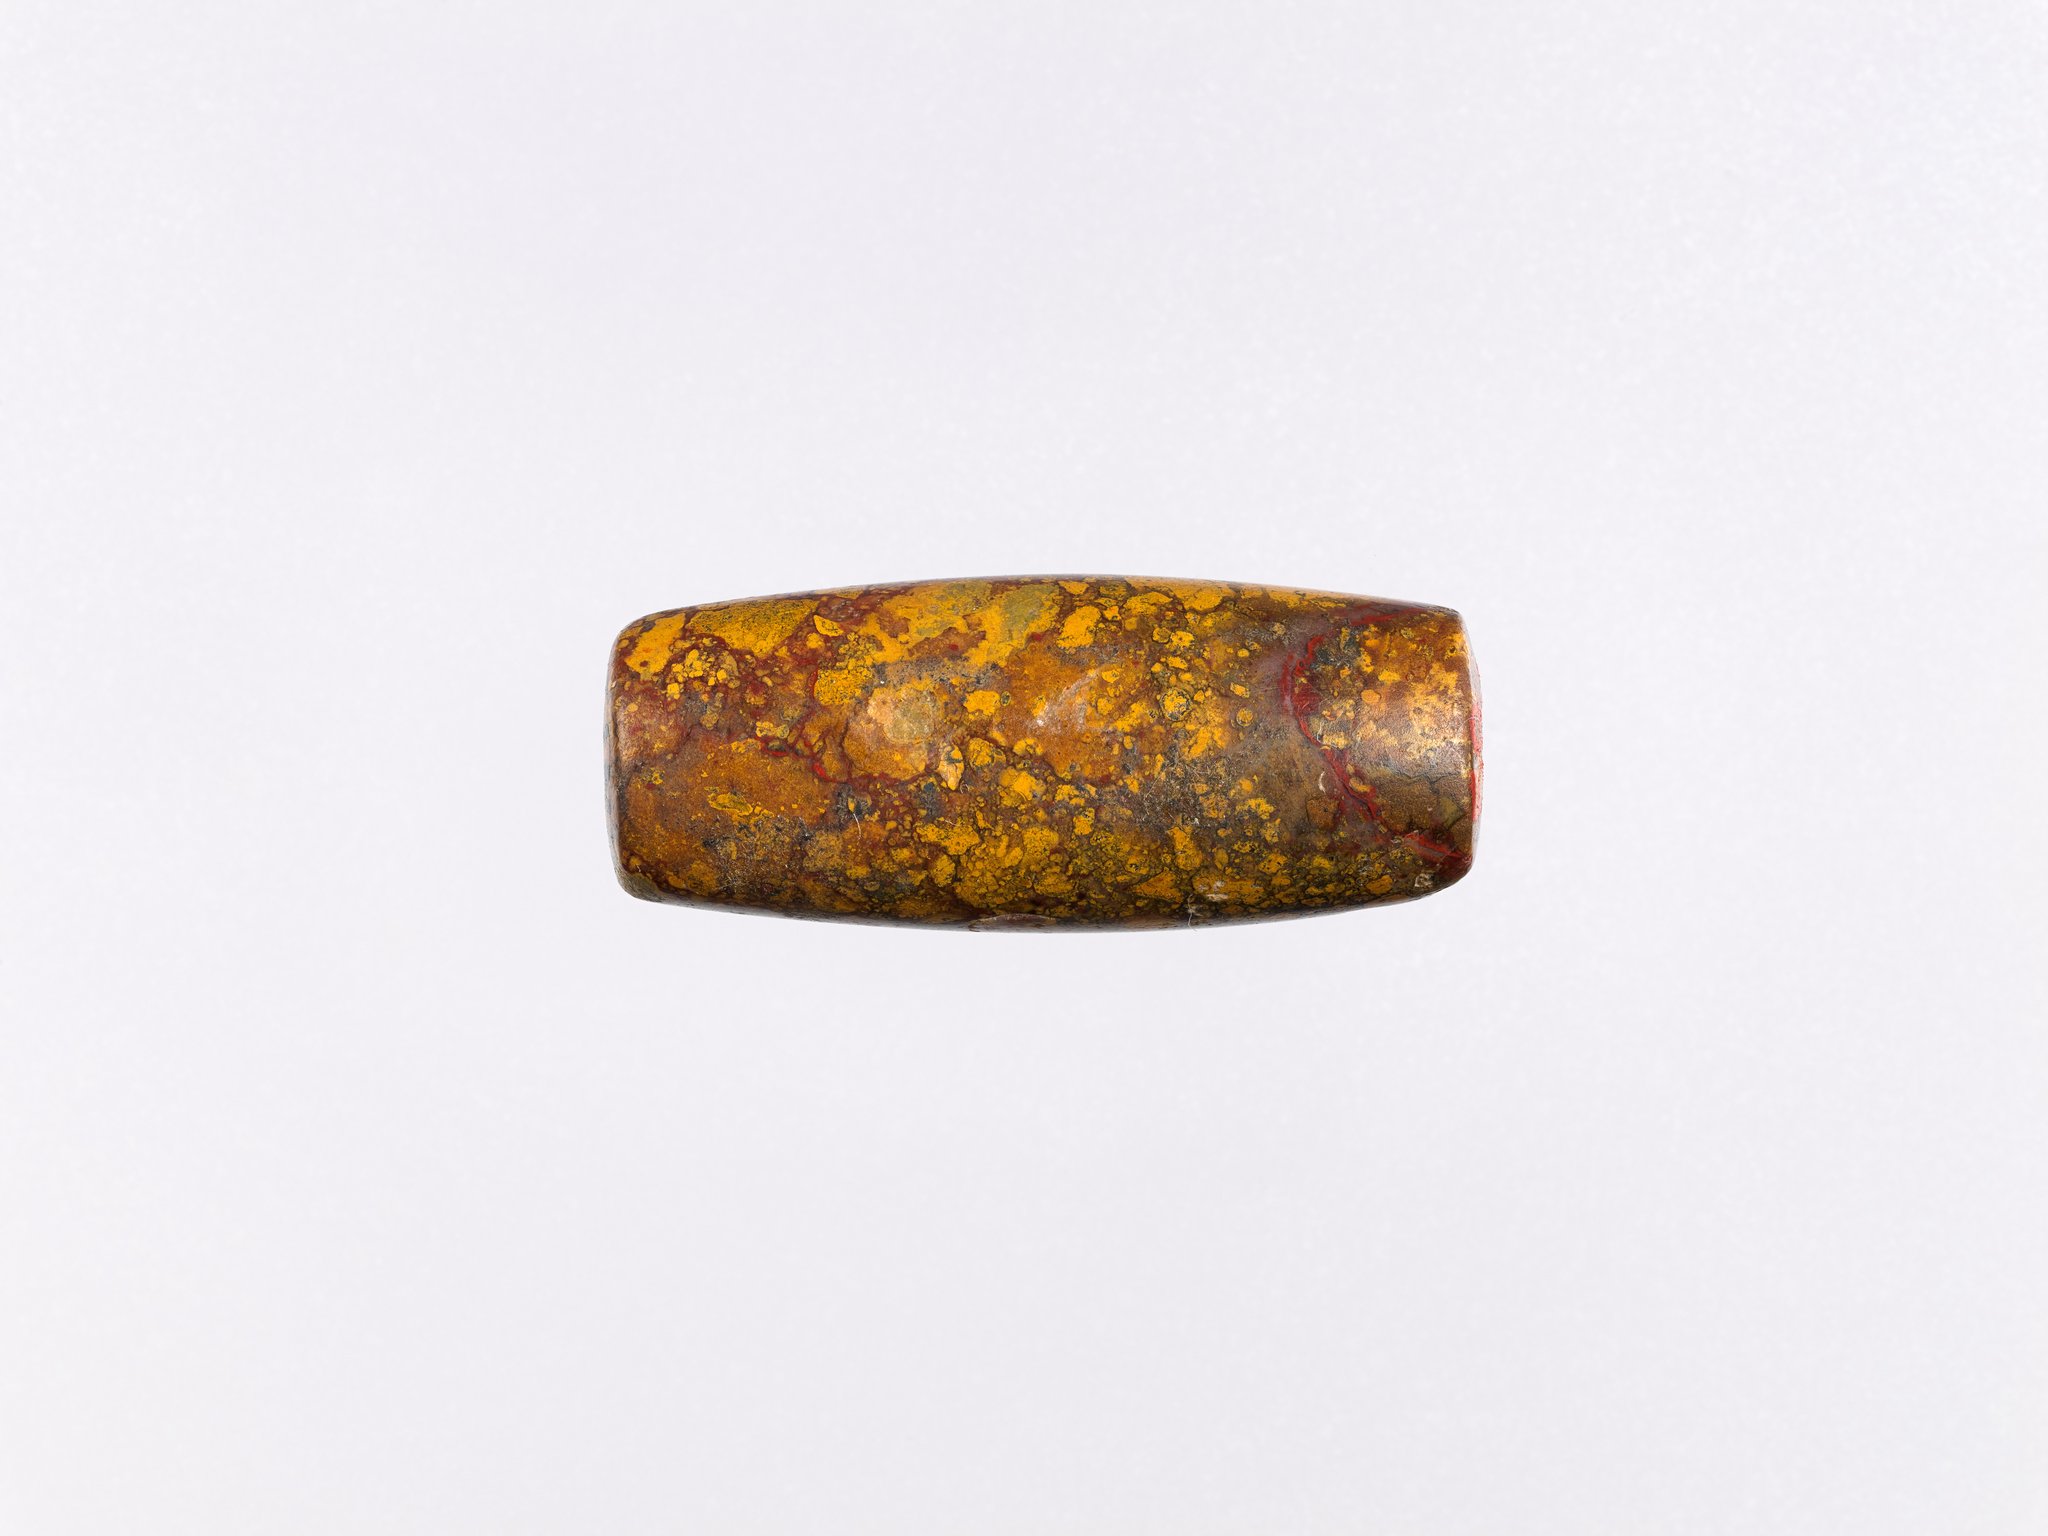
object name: bead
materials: stone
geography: mesopotamia